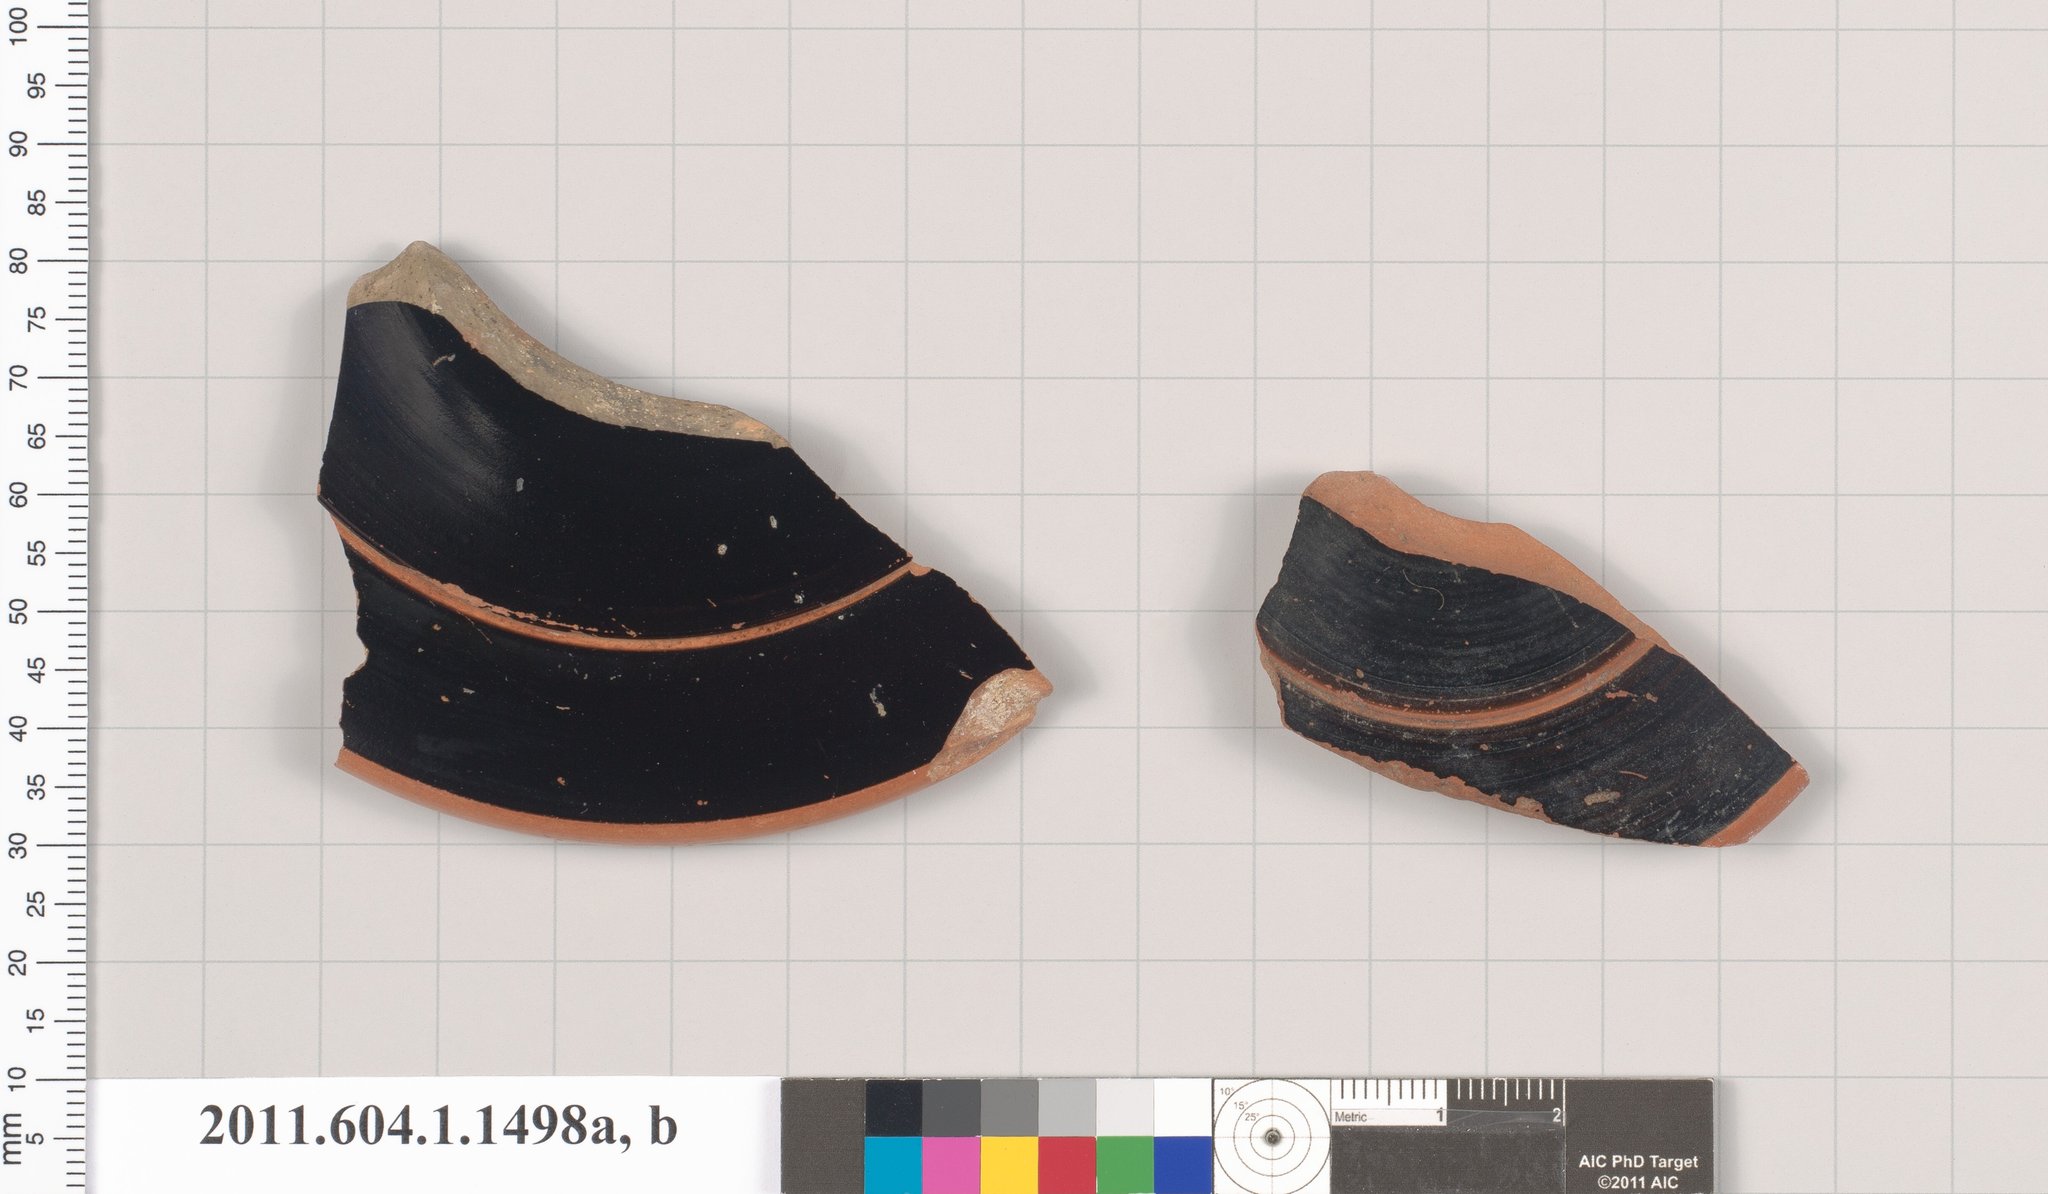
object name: kylix fragment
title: Terracotta fragments of kylikes (drinking cups)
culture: greek, attic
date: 500-401 BCE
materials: terracotta